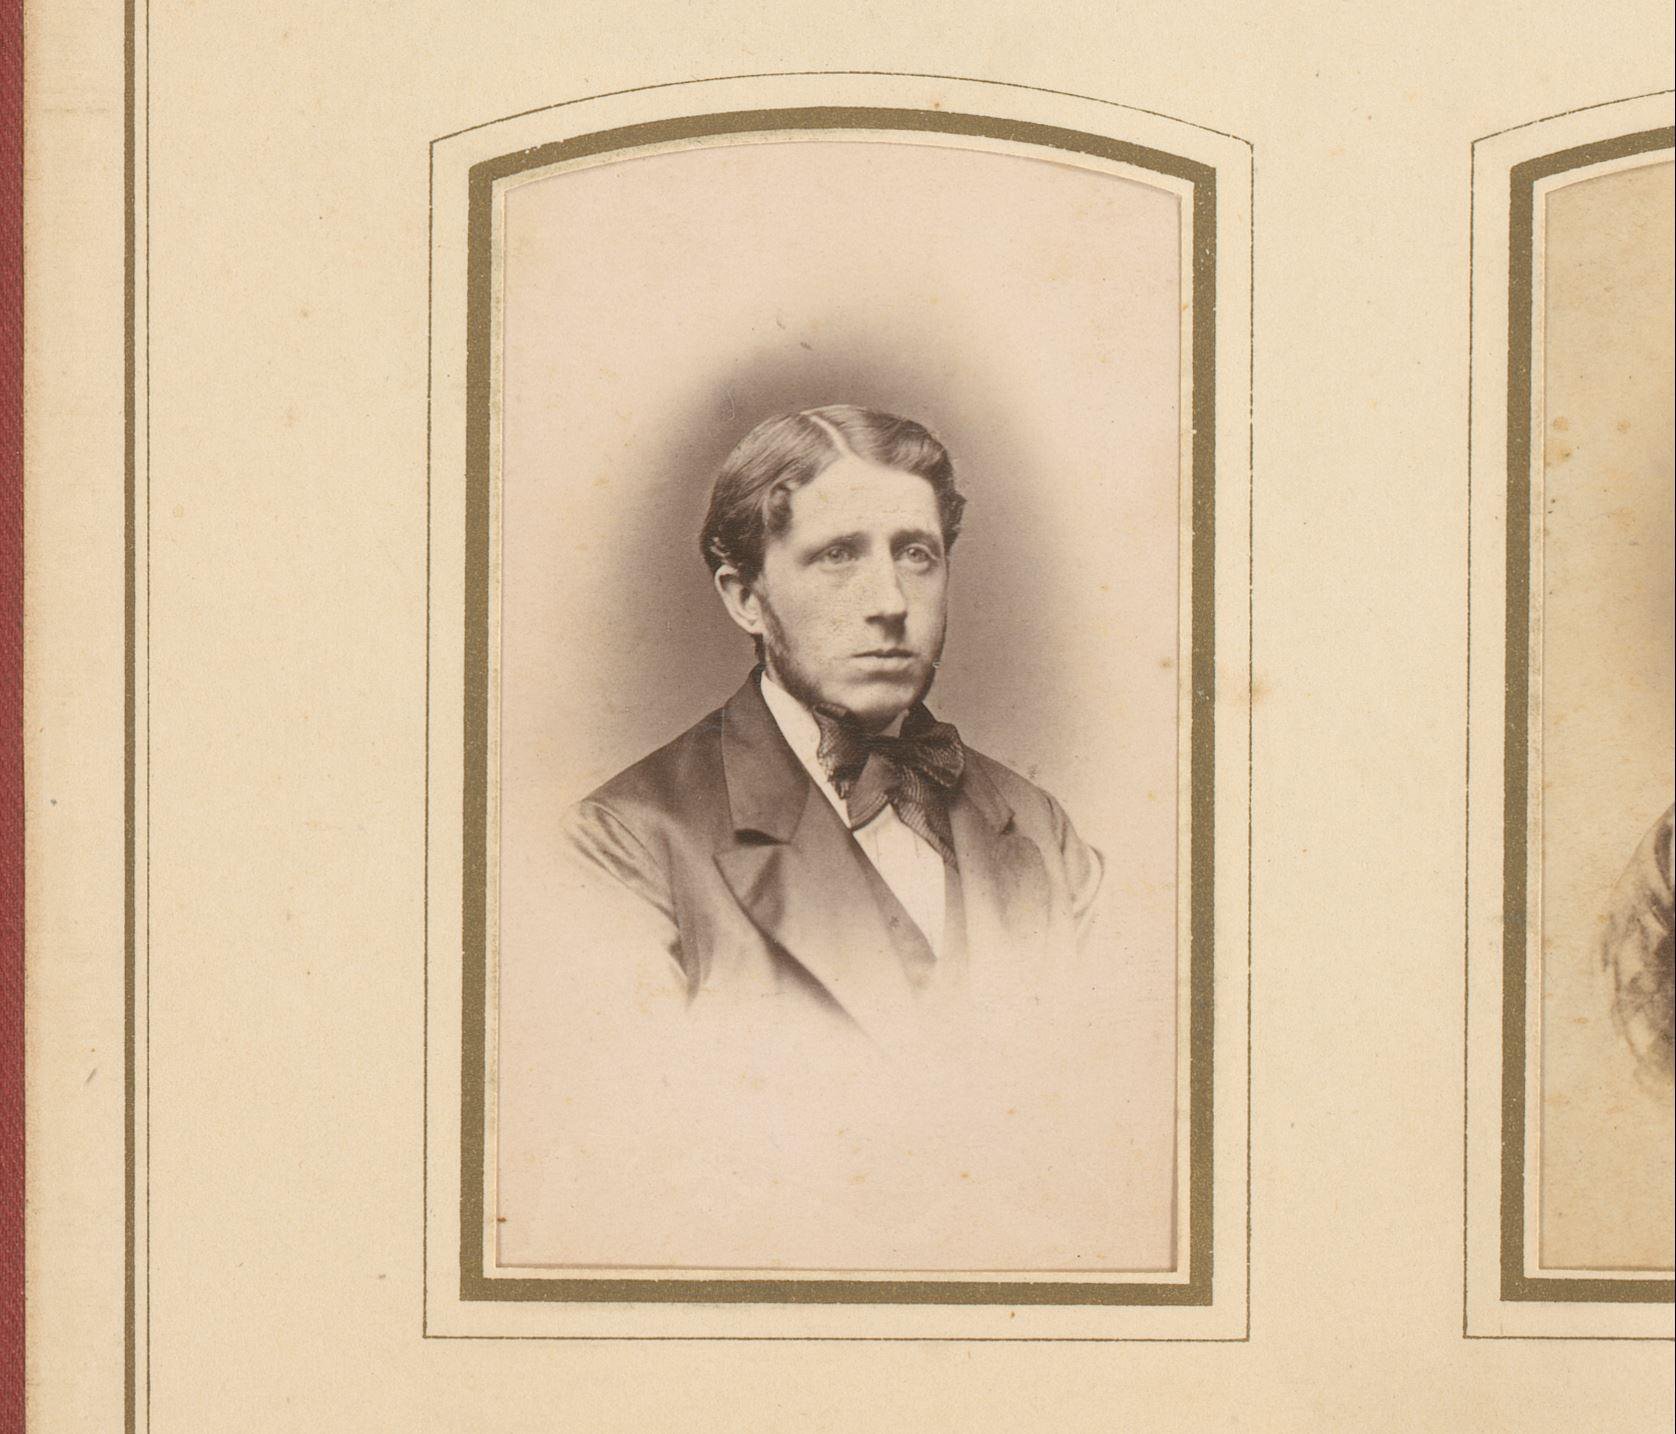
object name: photograph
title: Portret van een man met bakkebaarden en vlinderstrik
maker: thomas martin staas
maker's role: fotograaf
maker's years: 1844-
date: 1865-1895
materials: cardboard, photographic support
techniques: albumen print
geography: leeuwarden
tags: sideburns, historical persons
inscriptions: inscription: ‘Th. M. Staas/ Photograaf van Z.M. den Koning der Nederlanden/ Firma: E. Fuchs/ Leeuwarden/ Willemskade Zuidzijde Let. L 285./ Voor nabestellingen en vergootingen/ worden alle negatieven bewaard.’